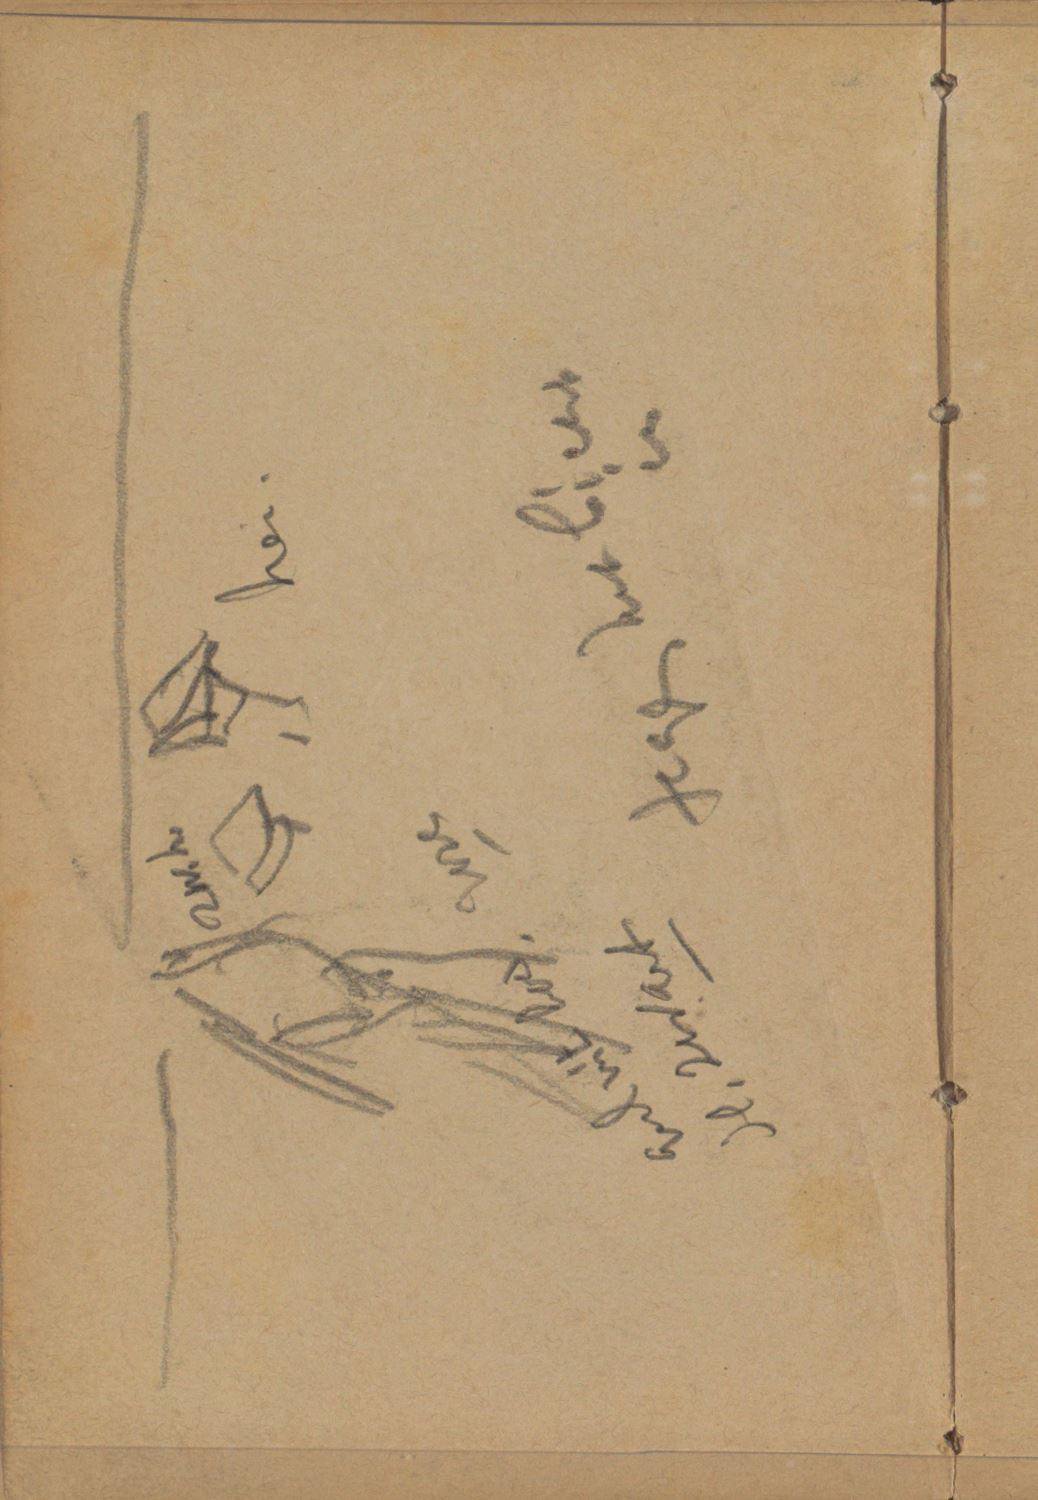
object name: sketchbook leaf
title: Figuurstudies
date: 1887-1891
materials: paper, pencil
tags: adult woman, adult man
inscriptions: kleurnotitie, handgeschreven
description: Pagina 23 uit een schetsboek met 83 bladen.